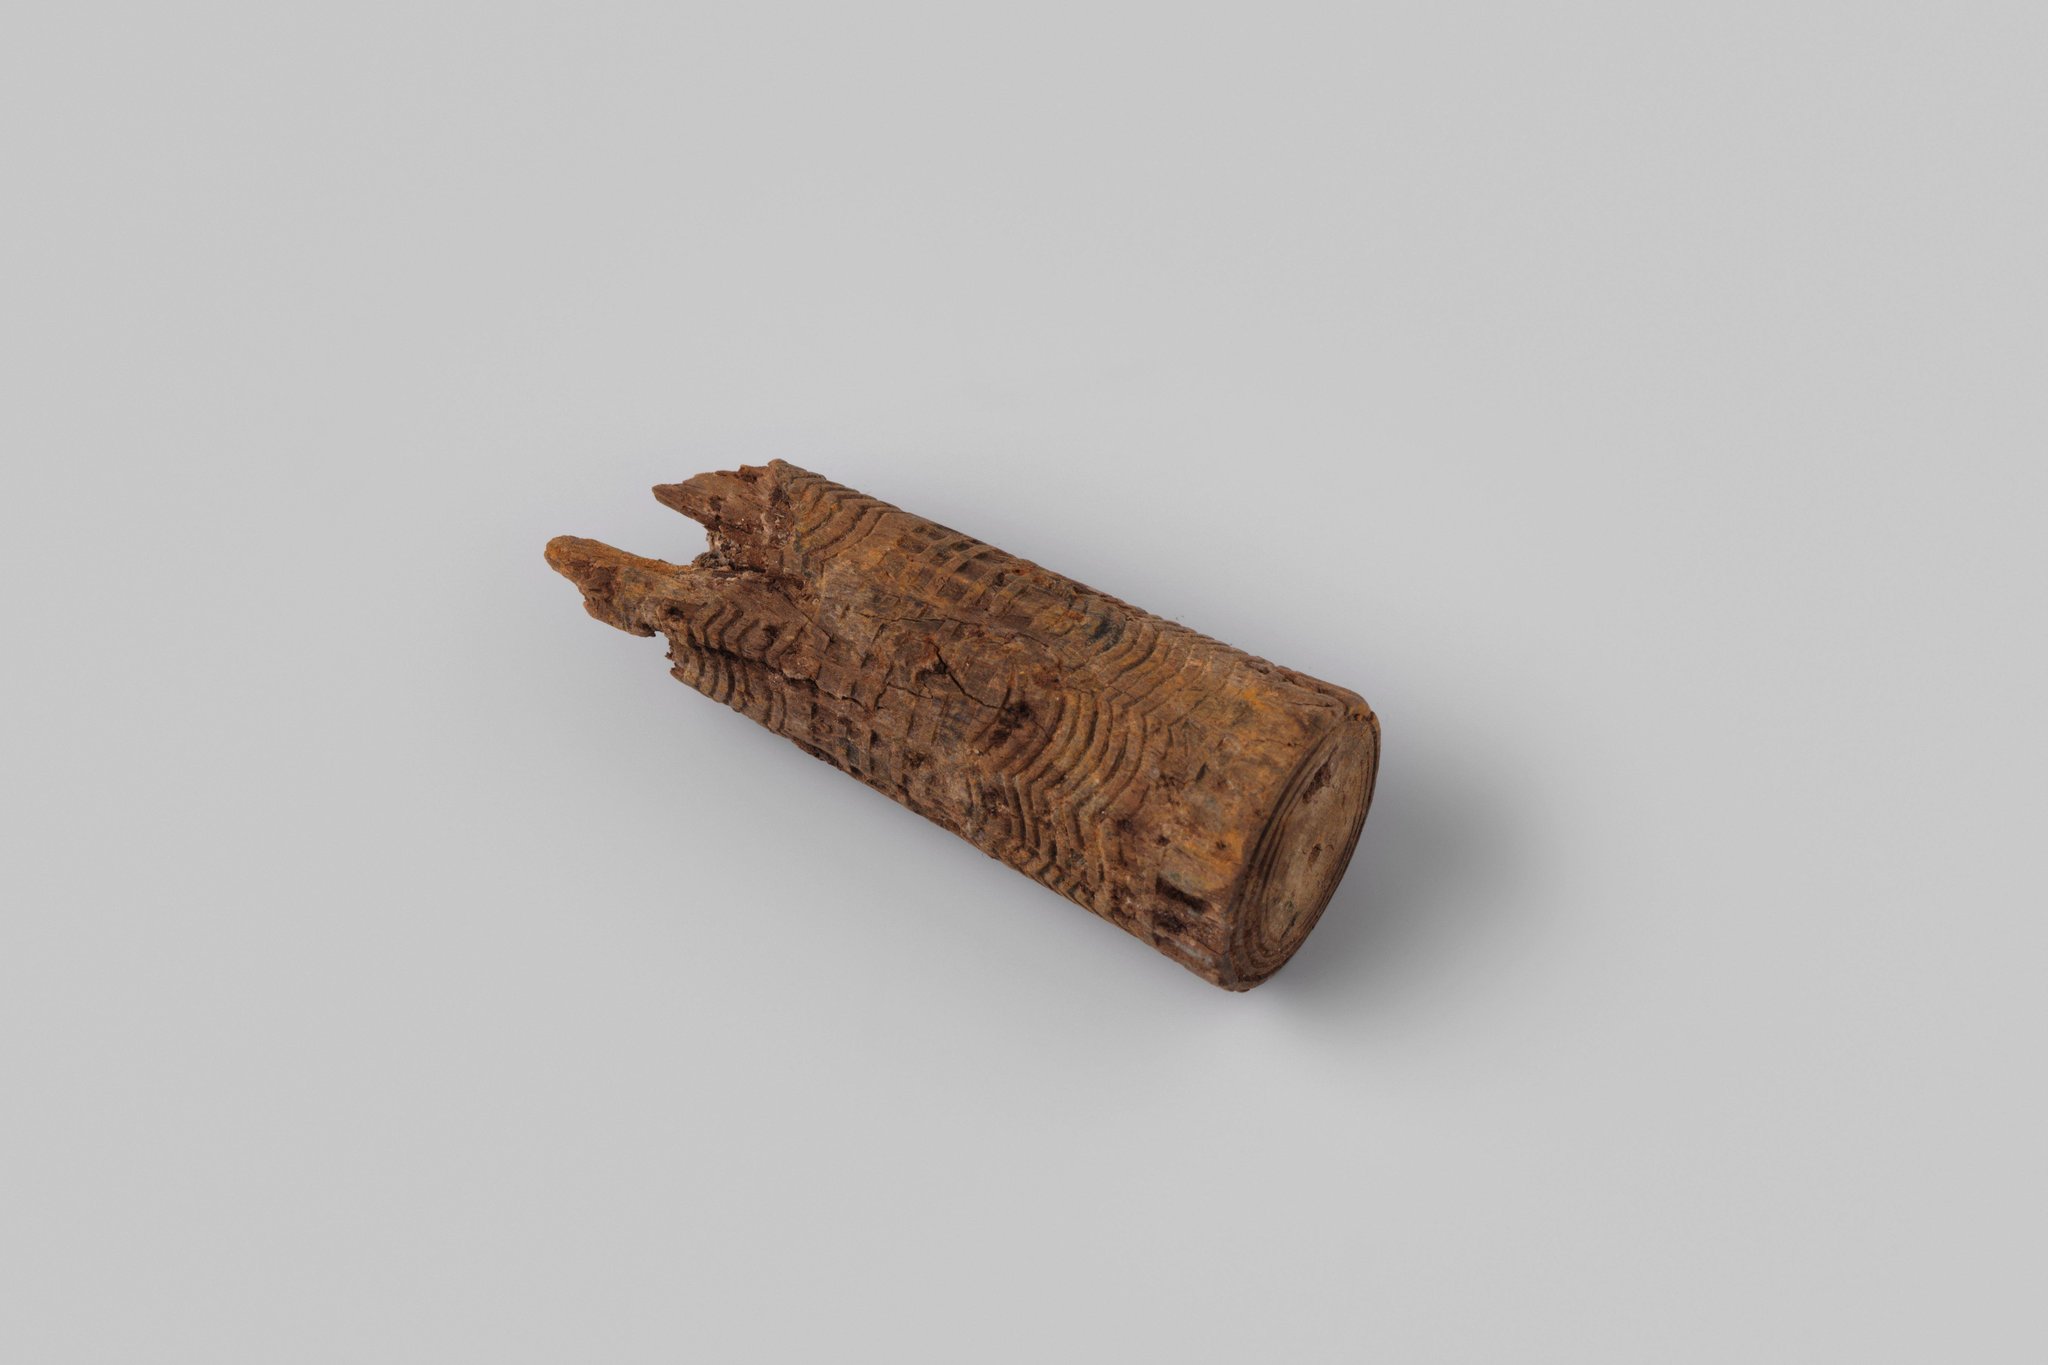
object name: knife handle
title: Fragment messenheft uit het wrak van de Oost-Indiëvaarder Hollandia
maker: Anonymous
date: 1700-1743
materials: wood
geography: netherlands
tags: verenigde oostindische compagnie, hollandia (schip), annet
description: Knife, handle, cylindrical: tapering; id. NG 1979-403H, ferrules id. NG 1980-27H426.